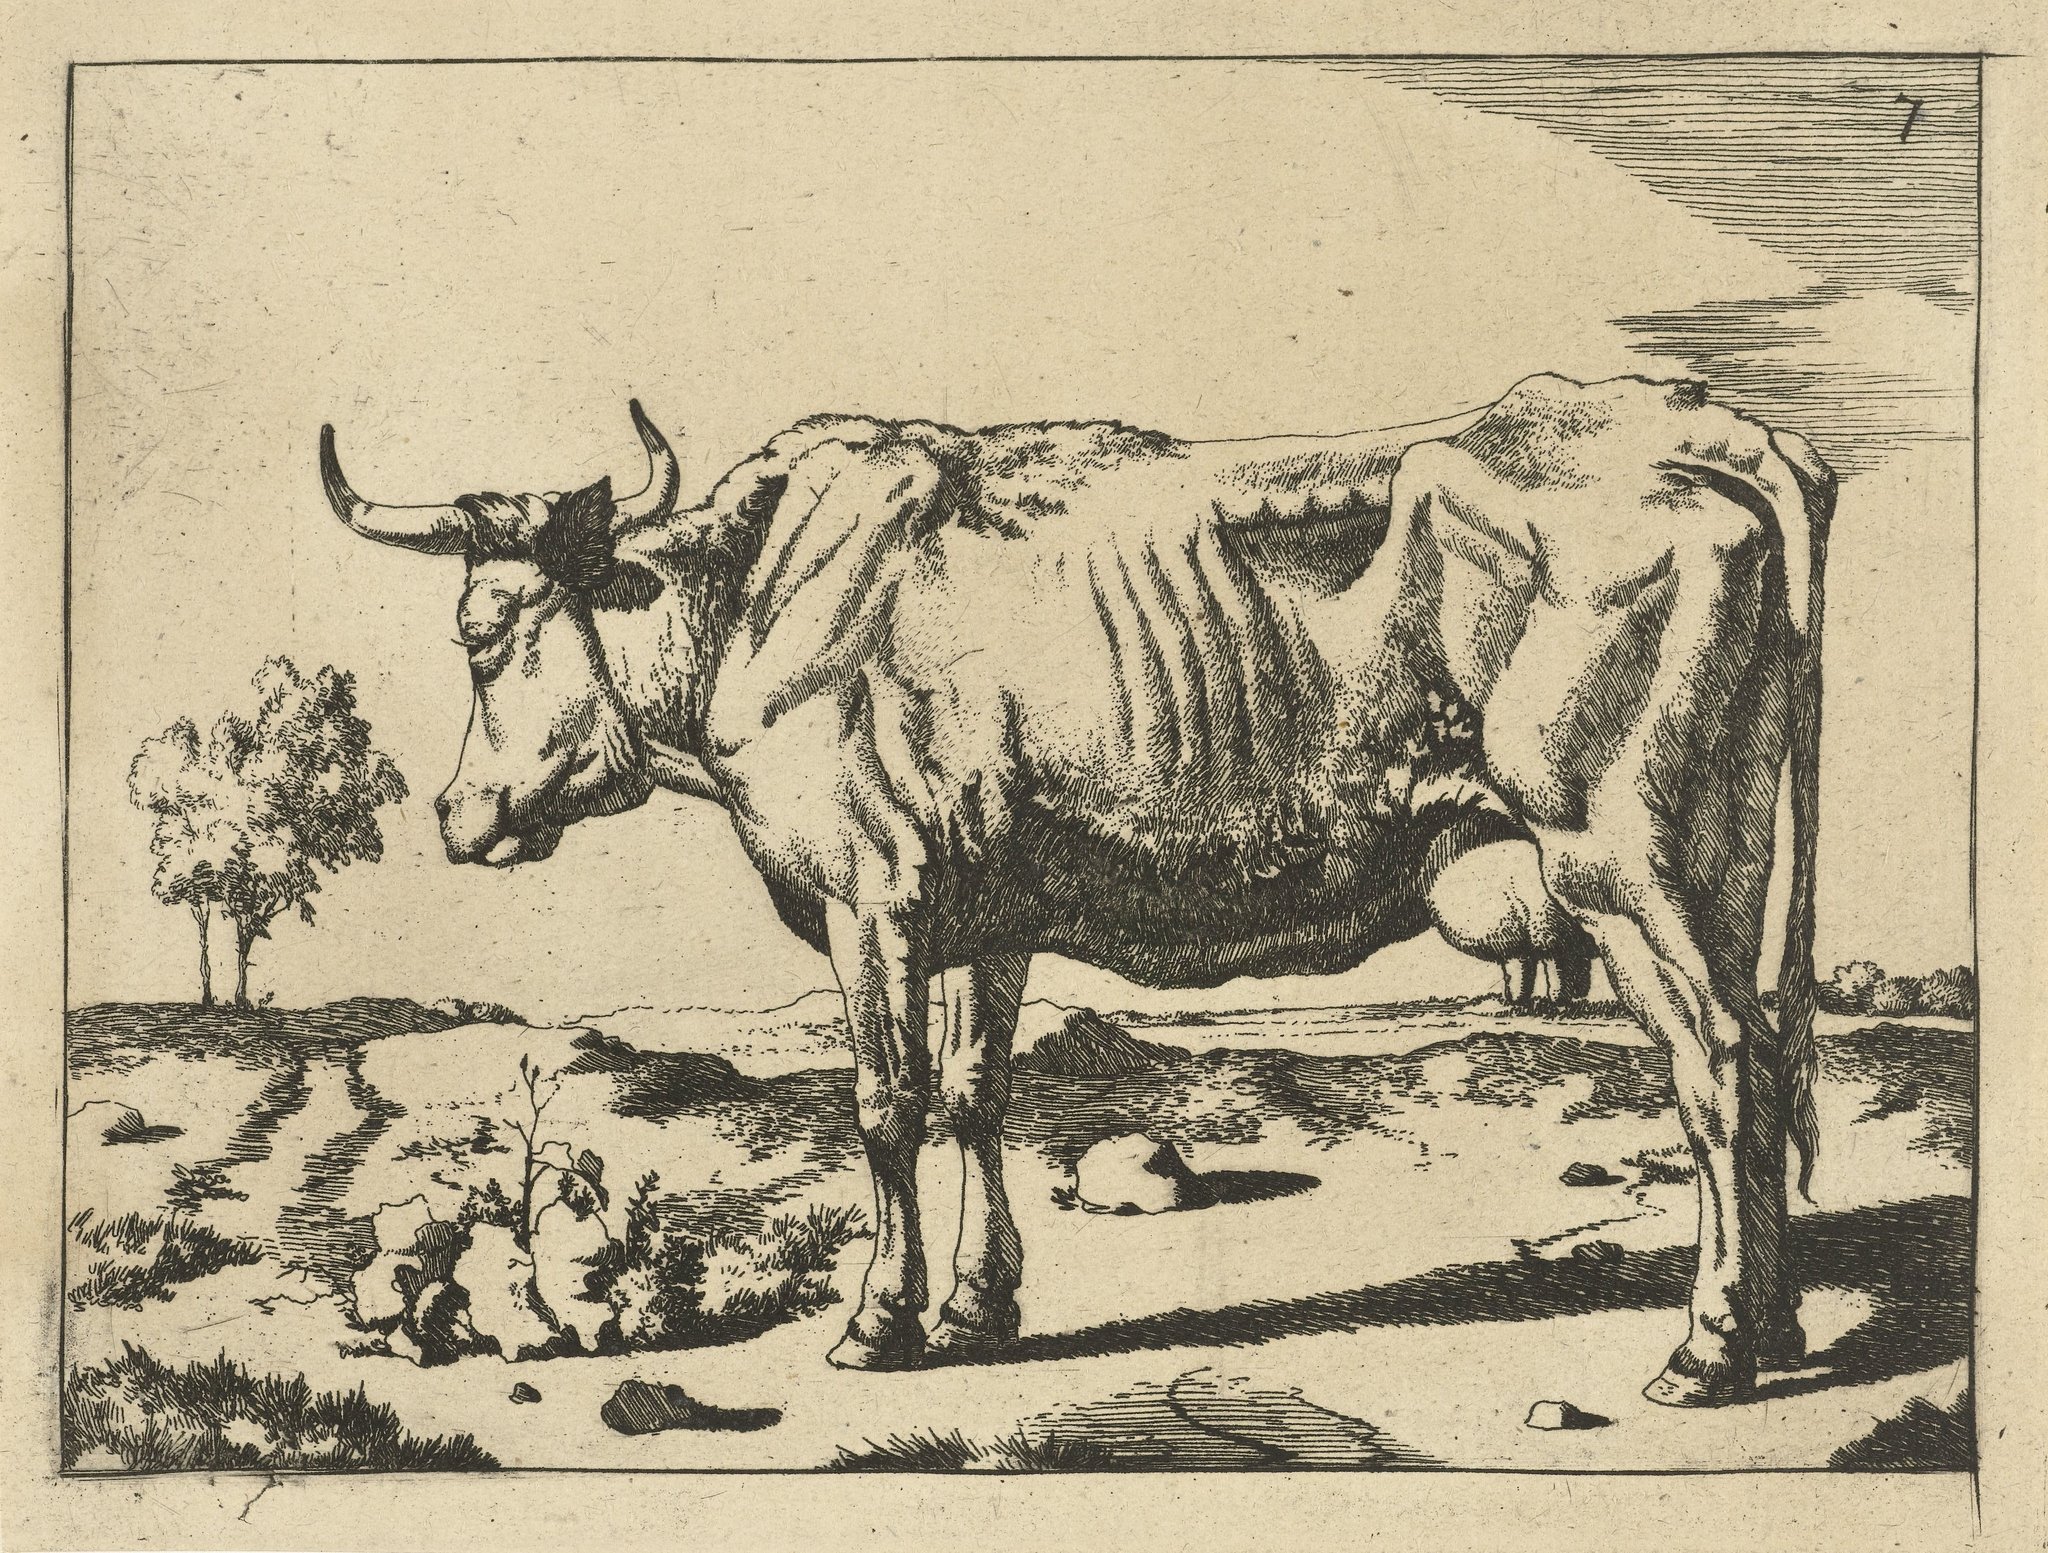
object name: print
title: Koeien en stieren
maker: marcus de bye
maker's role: print maker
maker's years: 1639-1688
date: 1657-1677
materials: paper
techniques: etching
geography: the hague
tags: cow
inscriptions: collector's mark: Lugt 2228